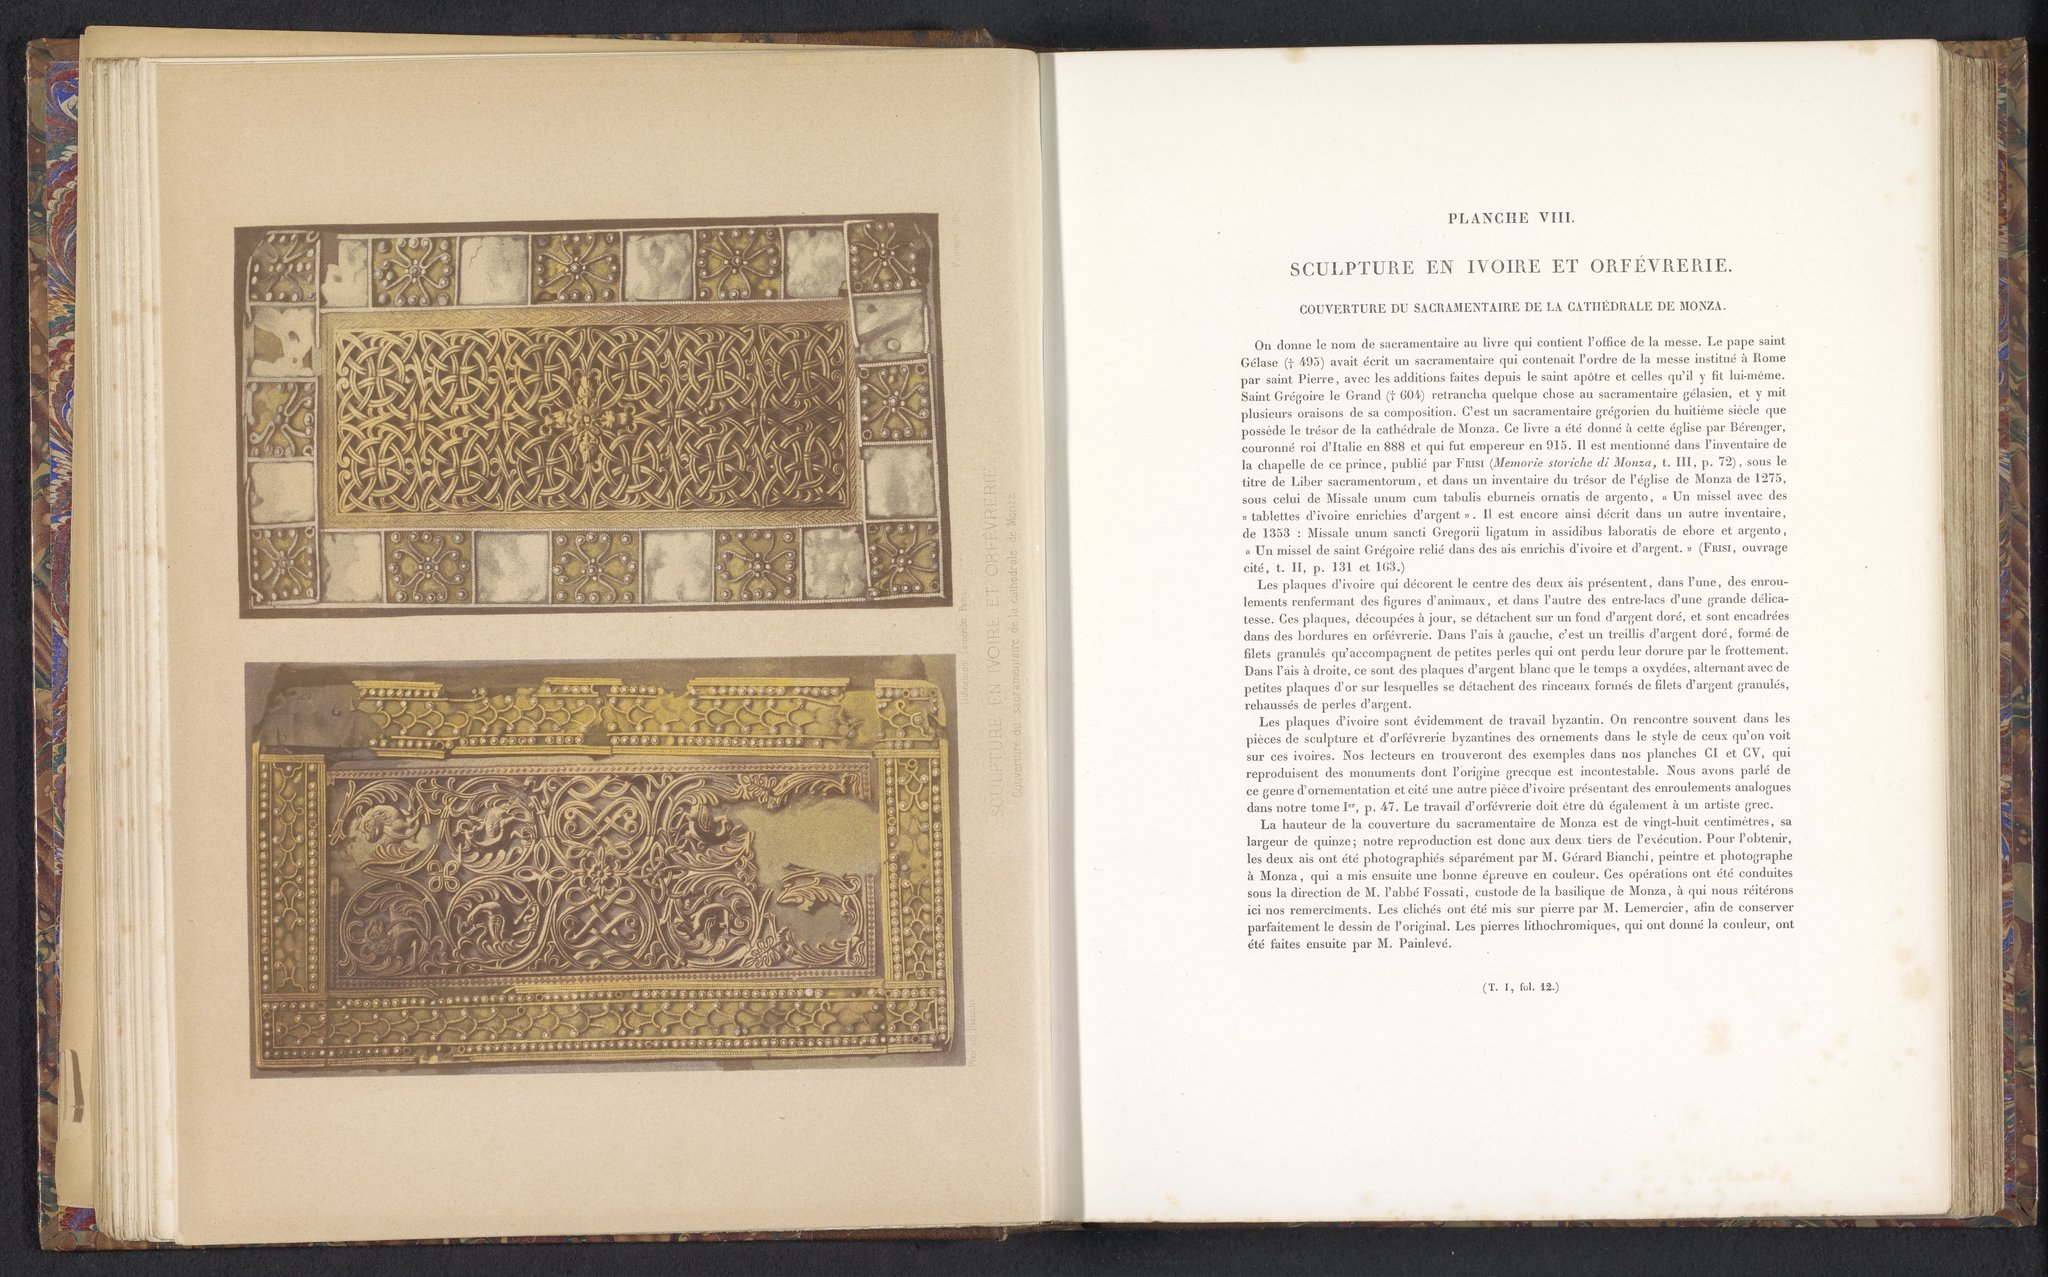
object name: photomechanical print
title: Couverture de sacramentaire de la cathédrale de Monza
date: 1859-1864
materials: paper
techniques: photolithography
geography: paris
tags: ornament ~ geometric motifs, sculpture (+ relief ~ sculpture)